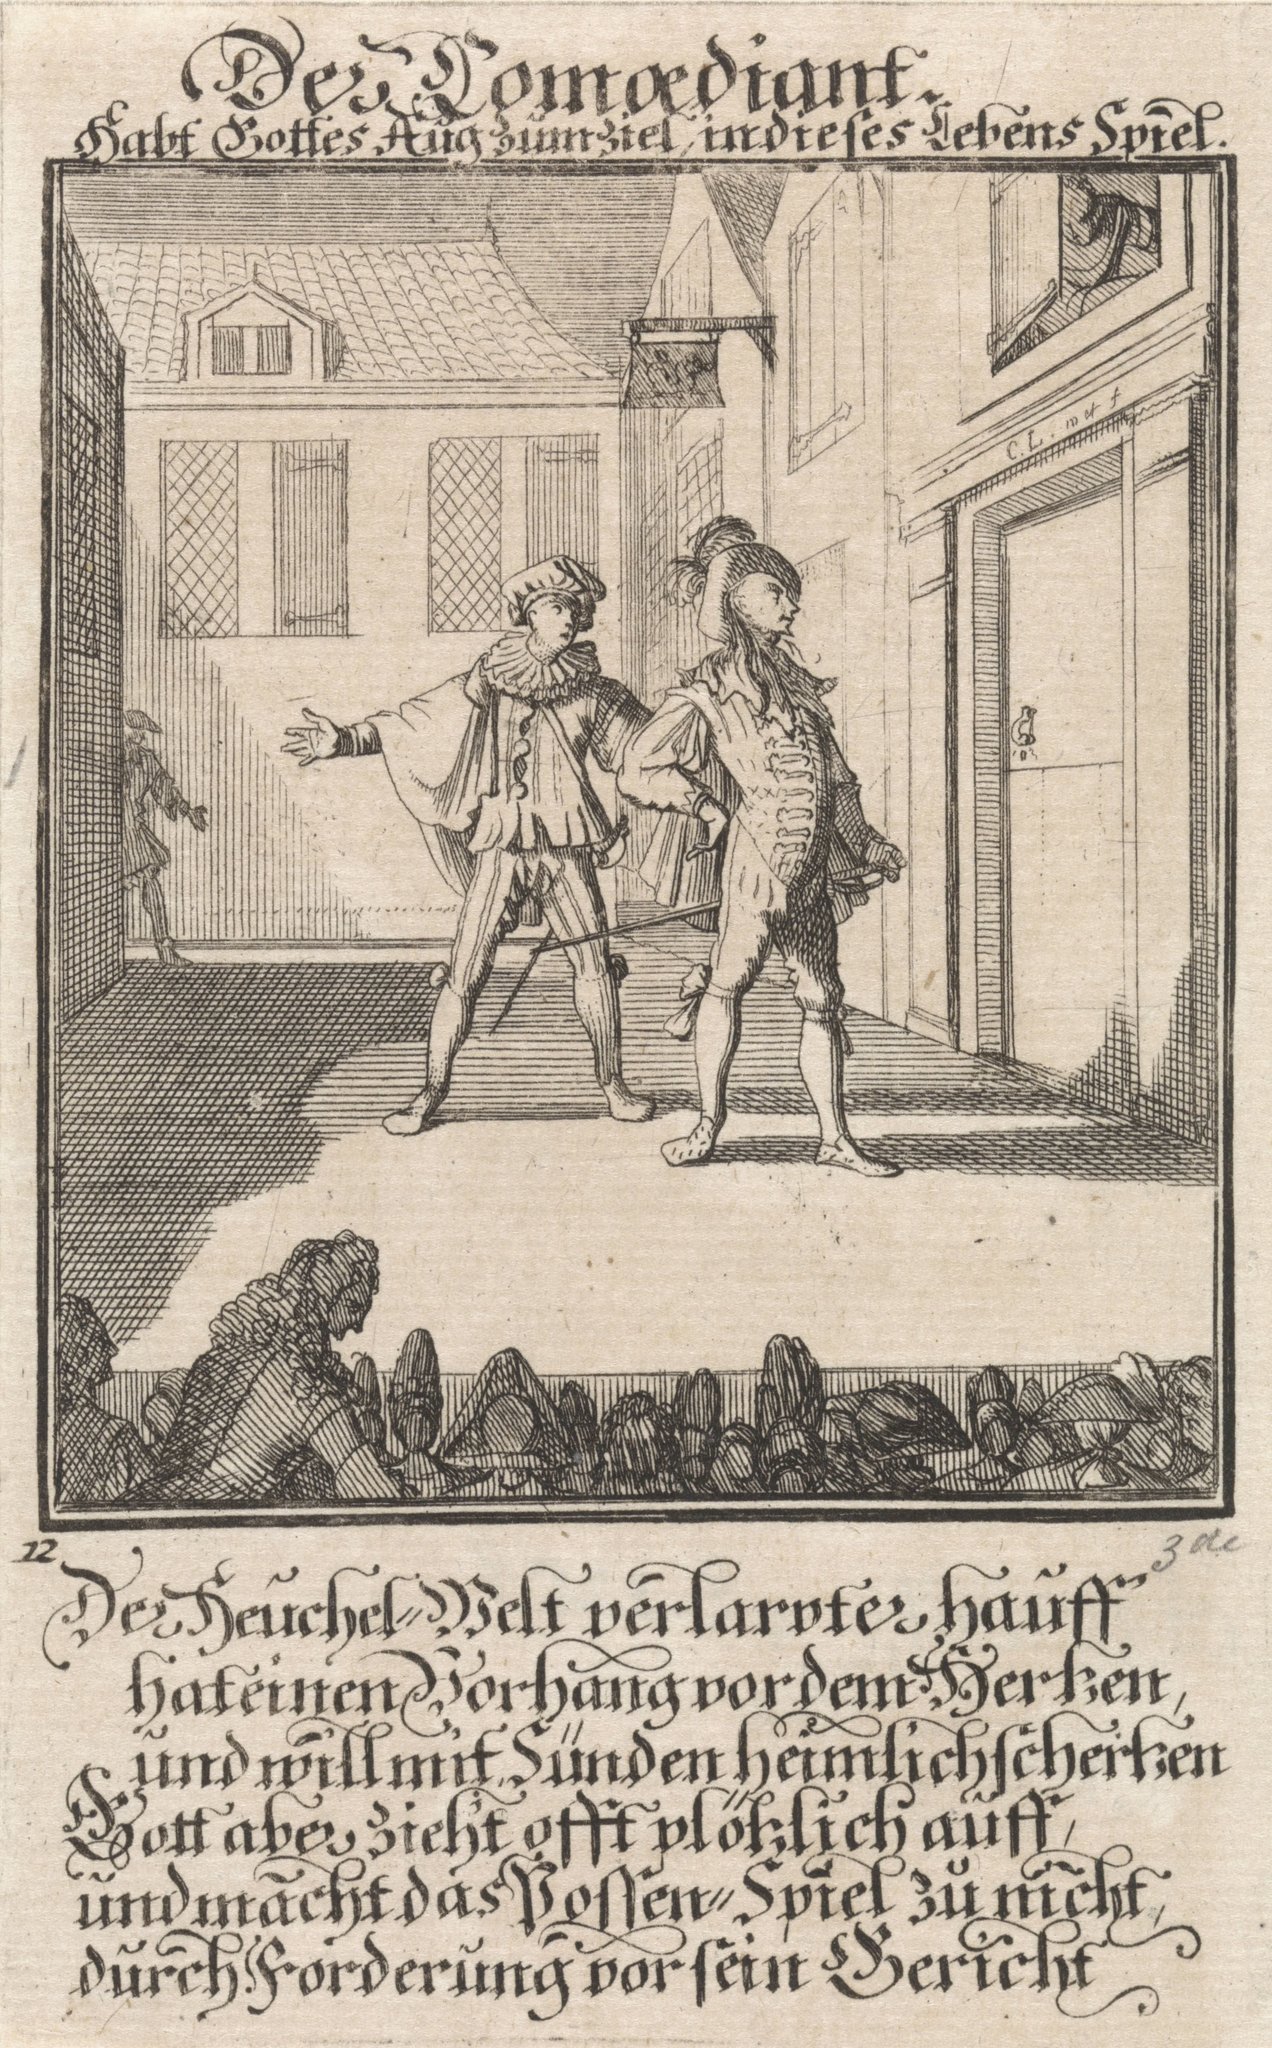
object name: print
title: Der Comoediant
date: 1711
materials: paper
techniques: etching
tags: comedy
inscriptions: collector's mark: Lugt 2228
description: Illustratie uit: Sancta Clara, Abraham à. Etwas für Alle, das ist: Eine kurtze Beschreibung allerley Stands- Ambts- und Gewerbs-Persohnen (...), 3 delen (1699-1733). Würtzburg: Martin Frantz Hertz, 1711, dl. III, p. 105. Het betreft hier de tweede druk van deel III.